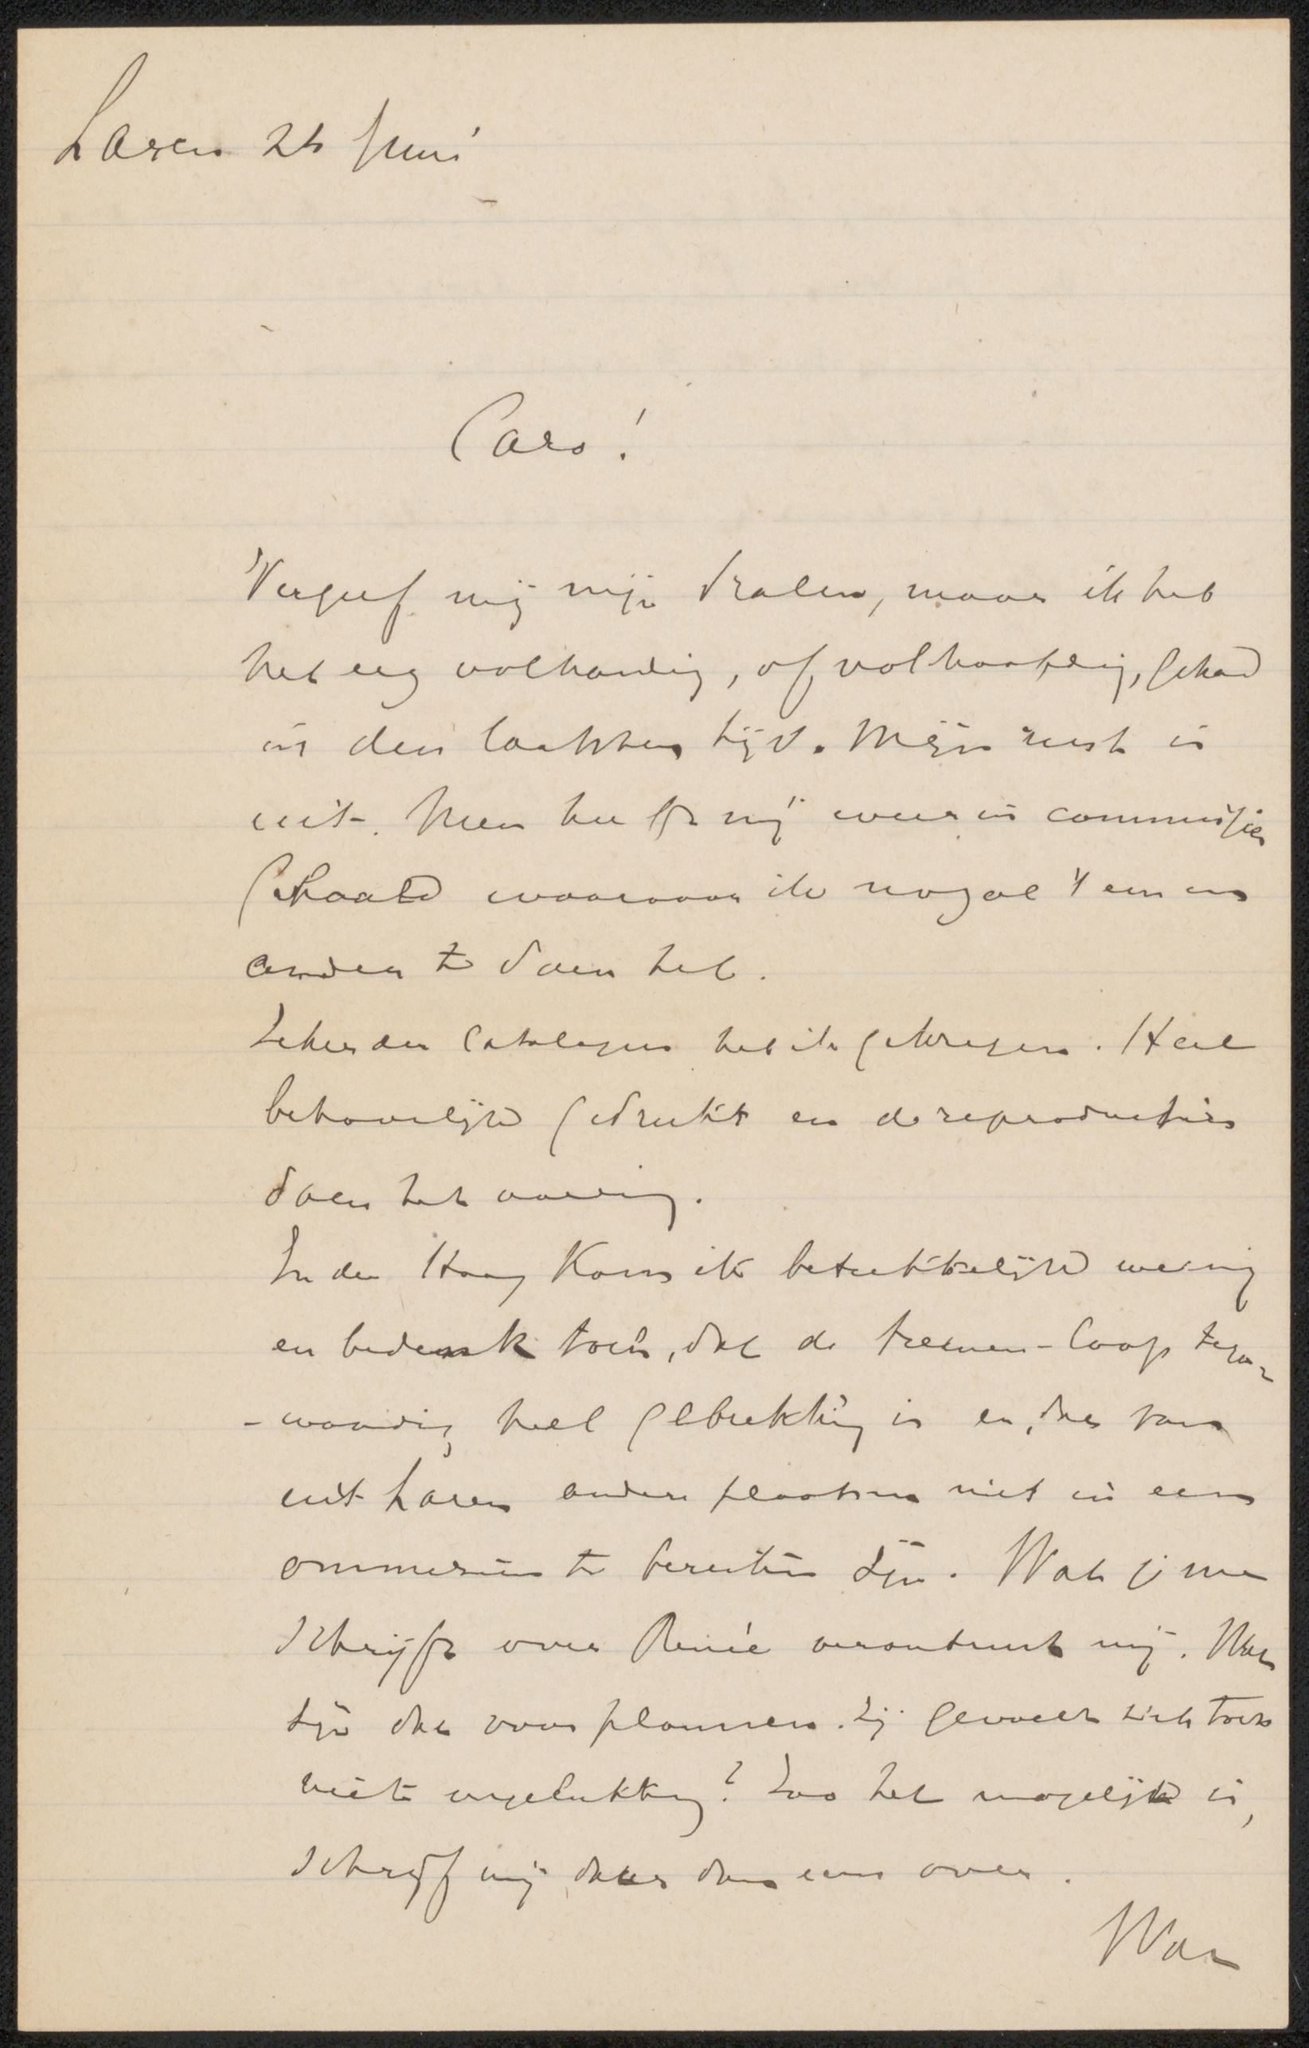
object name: letter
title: Brief aan Philip Zilcken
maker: adriaan pit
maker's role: print maker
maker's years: 1860-1944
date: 1918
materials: ink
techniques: pen, writing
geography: laren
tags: voorburg, renée hélène laure zilcken, painter, draughtsman, philip zilcken, printed matter, the hague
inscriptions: collector's mark: ‘RPK’